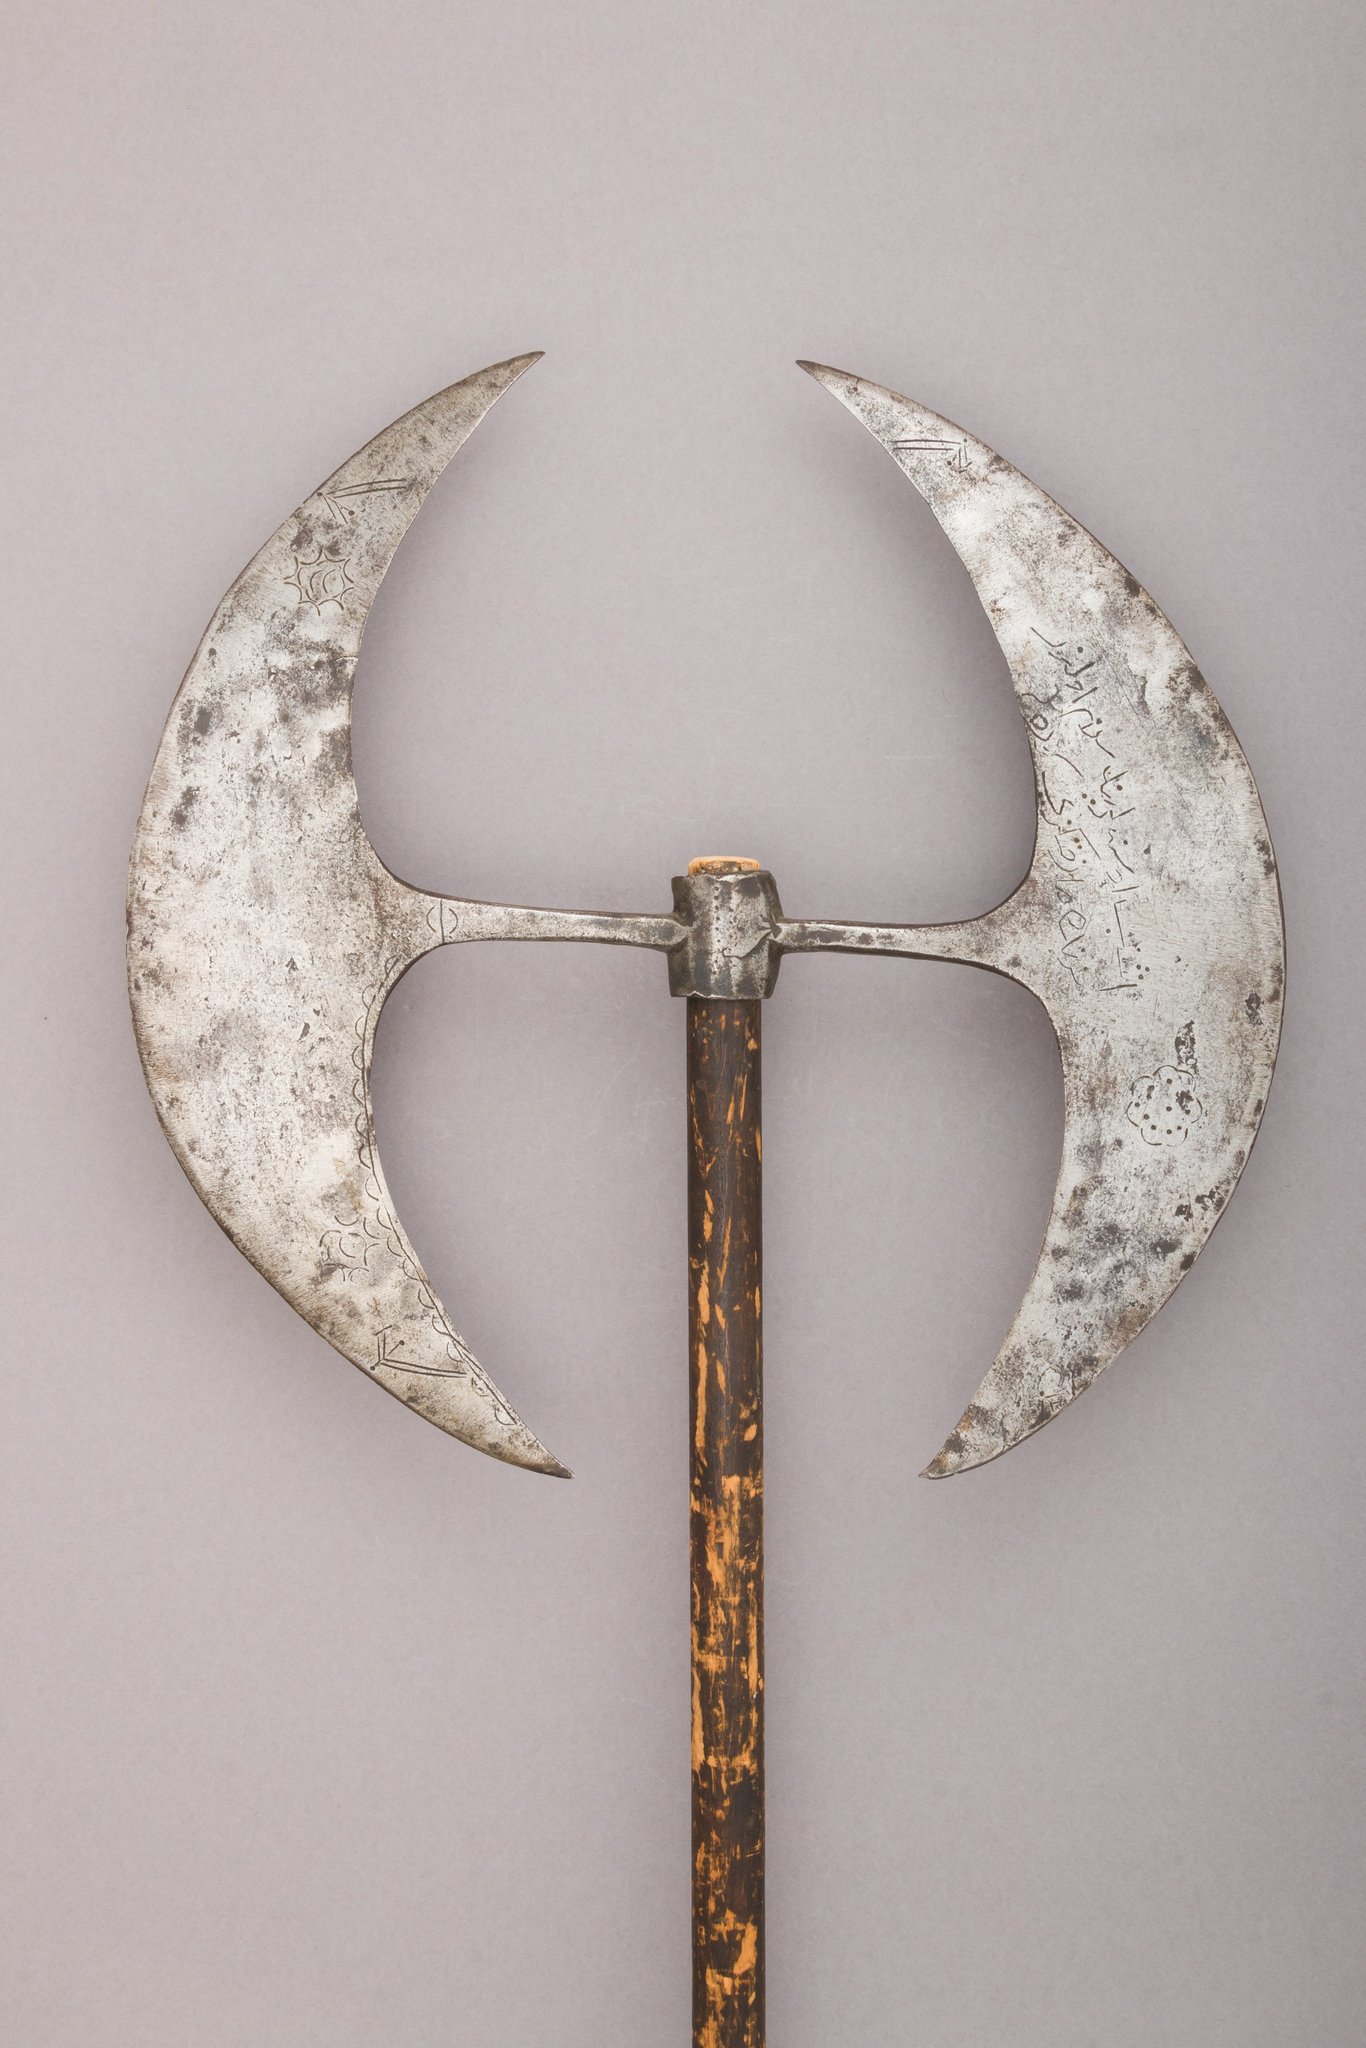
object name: axe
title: Double-bladed Processional Axe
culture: north indian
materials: steel, wood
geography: north india